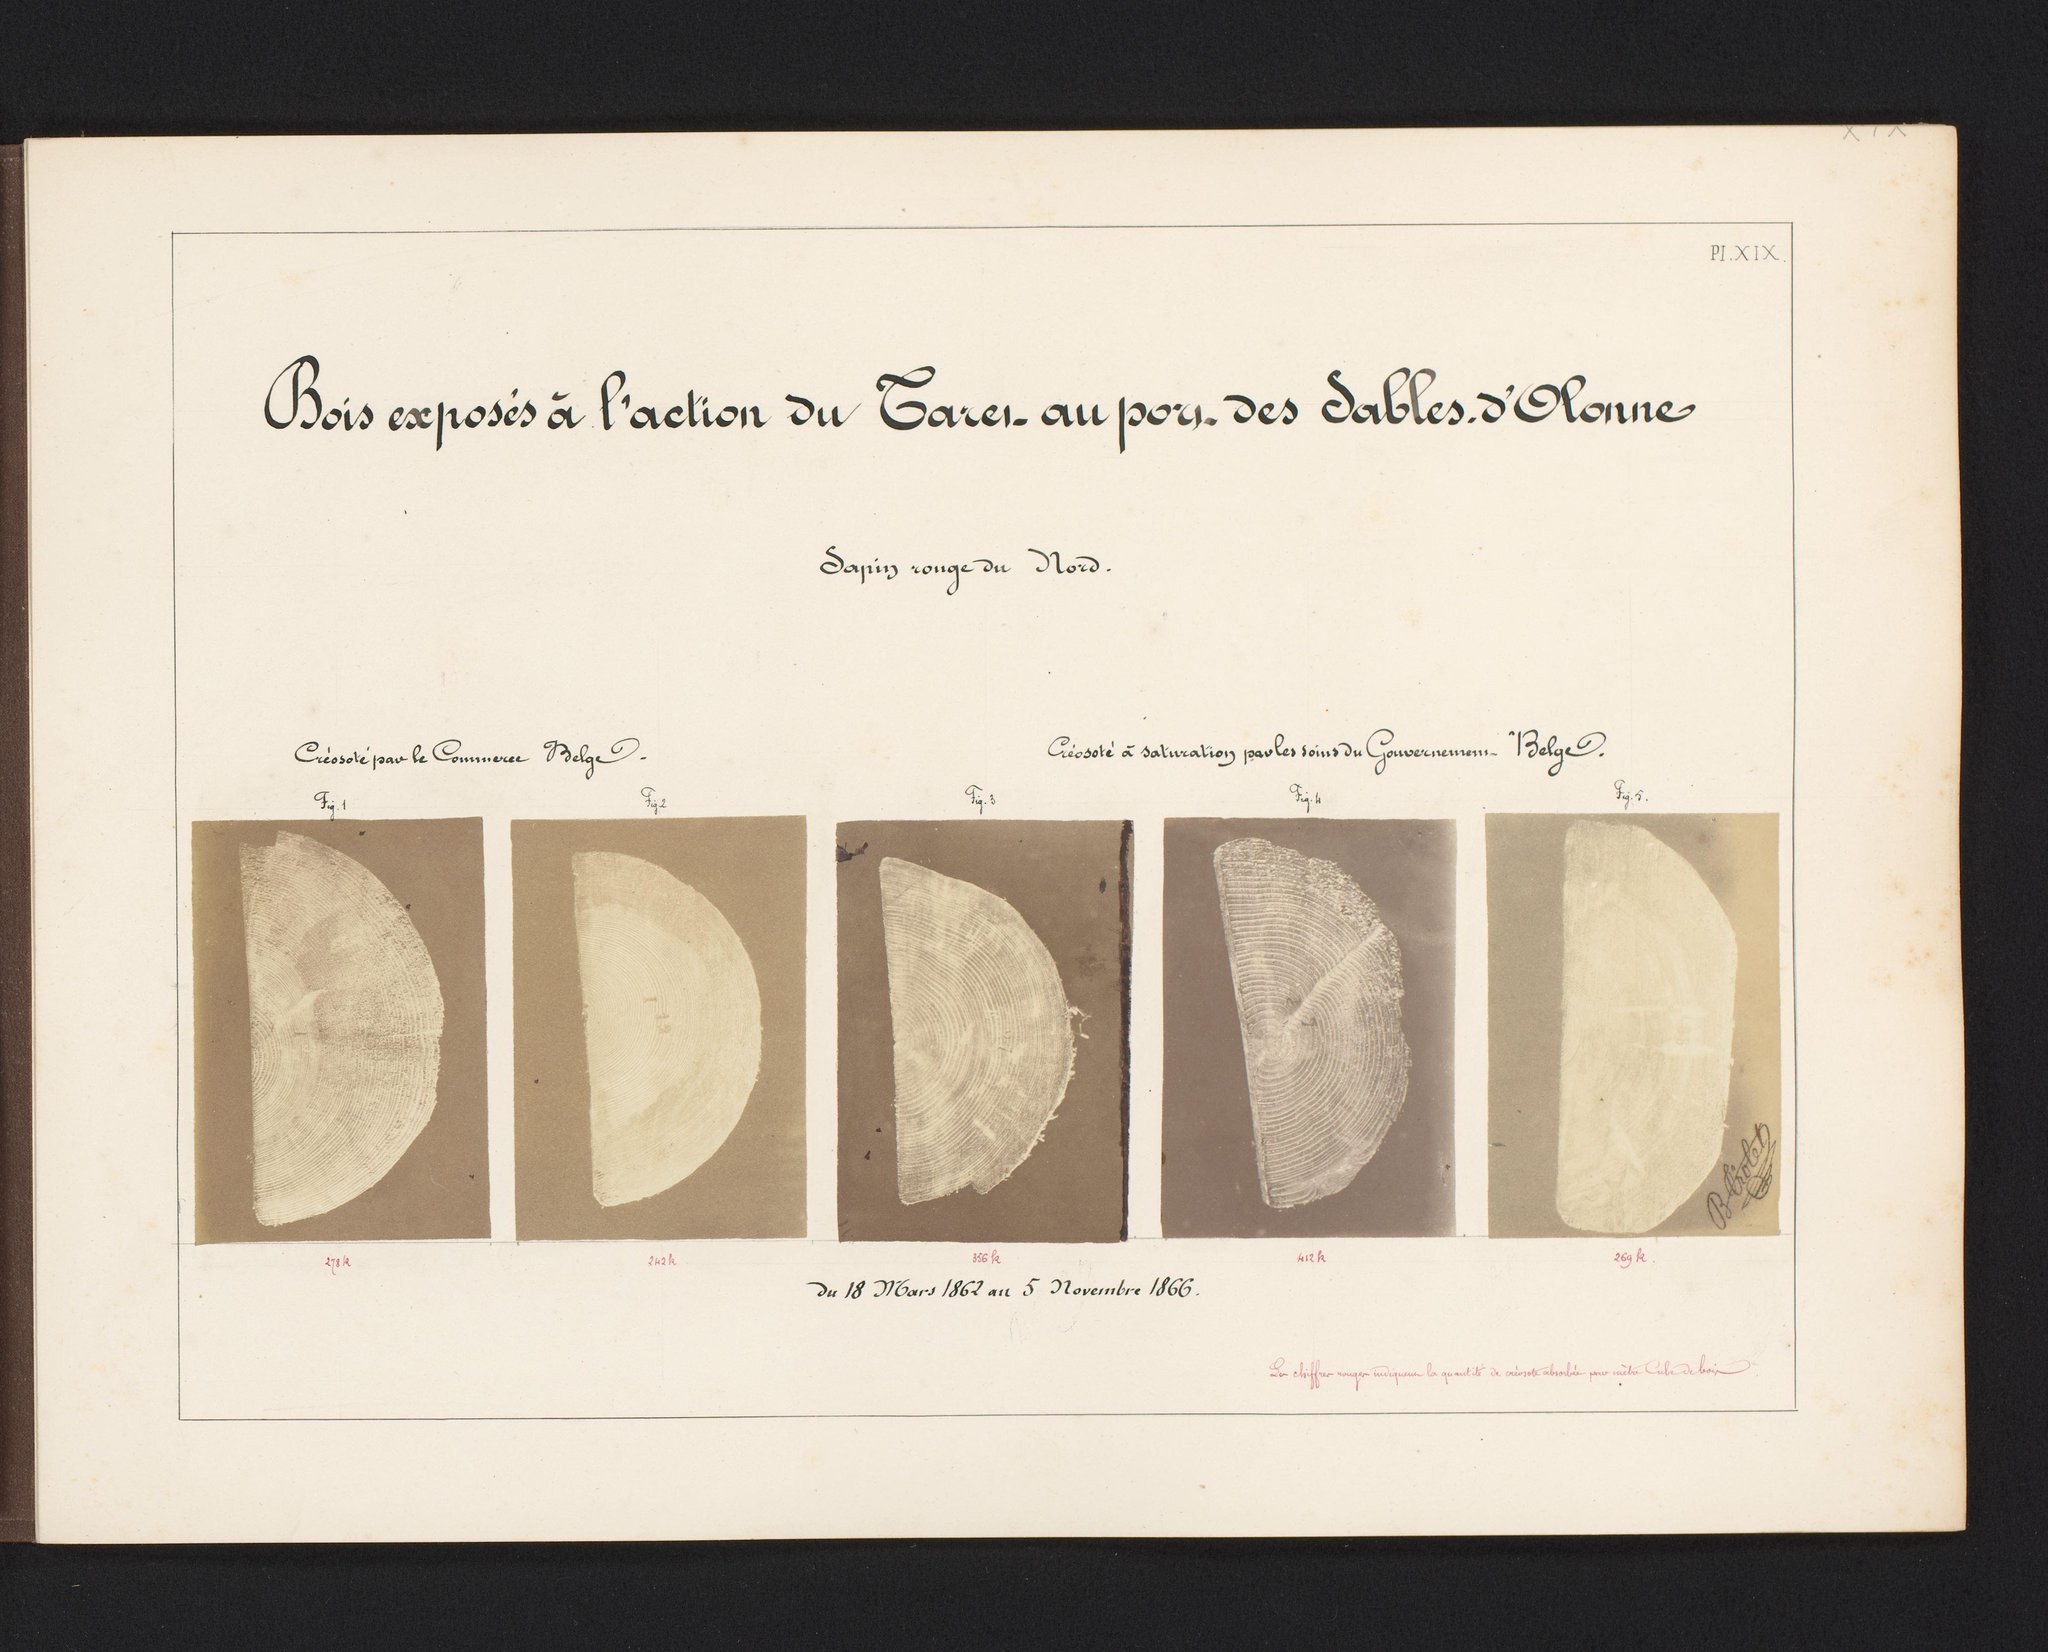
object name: photograph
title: Vijf stukken hout blootgesteld aan wormen, afkomstig uit de haven van Les Sables-d'Olonne, Frankrijk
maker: b. crolet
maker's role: fotograaf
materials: cardboard, photographic support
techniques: albumen print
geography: france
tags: worms, wood, timber ~ building material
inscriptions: signature: ‘B. Crolet’, number: ‘Pl. XIX.’, annotation: ‘Sapin rouge du Nord/ (...)/ mètre Cube de bois.’